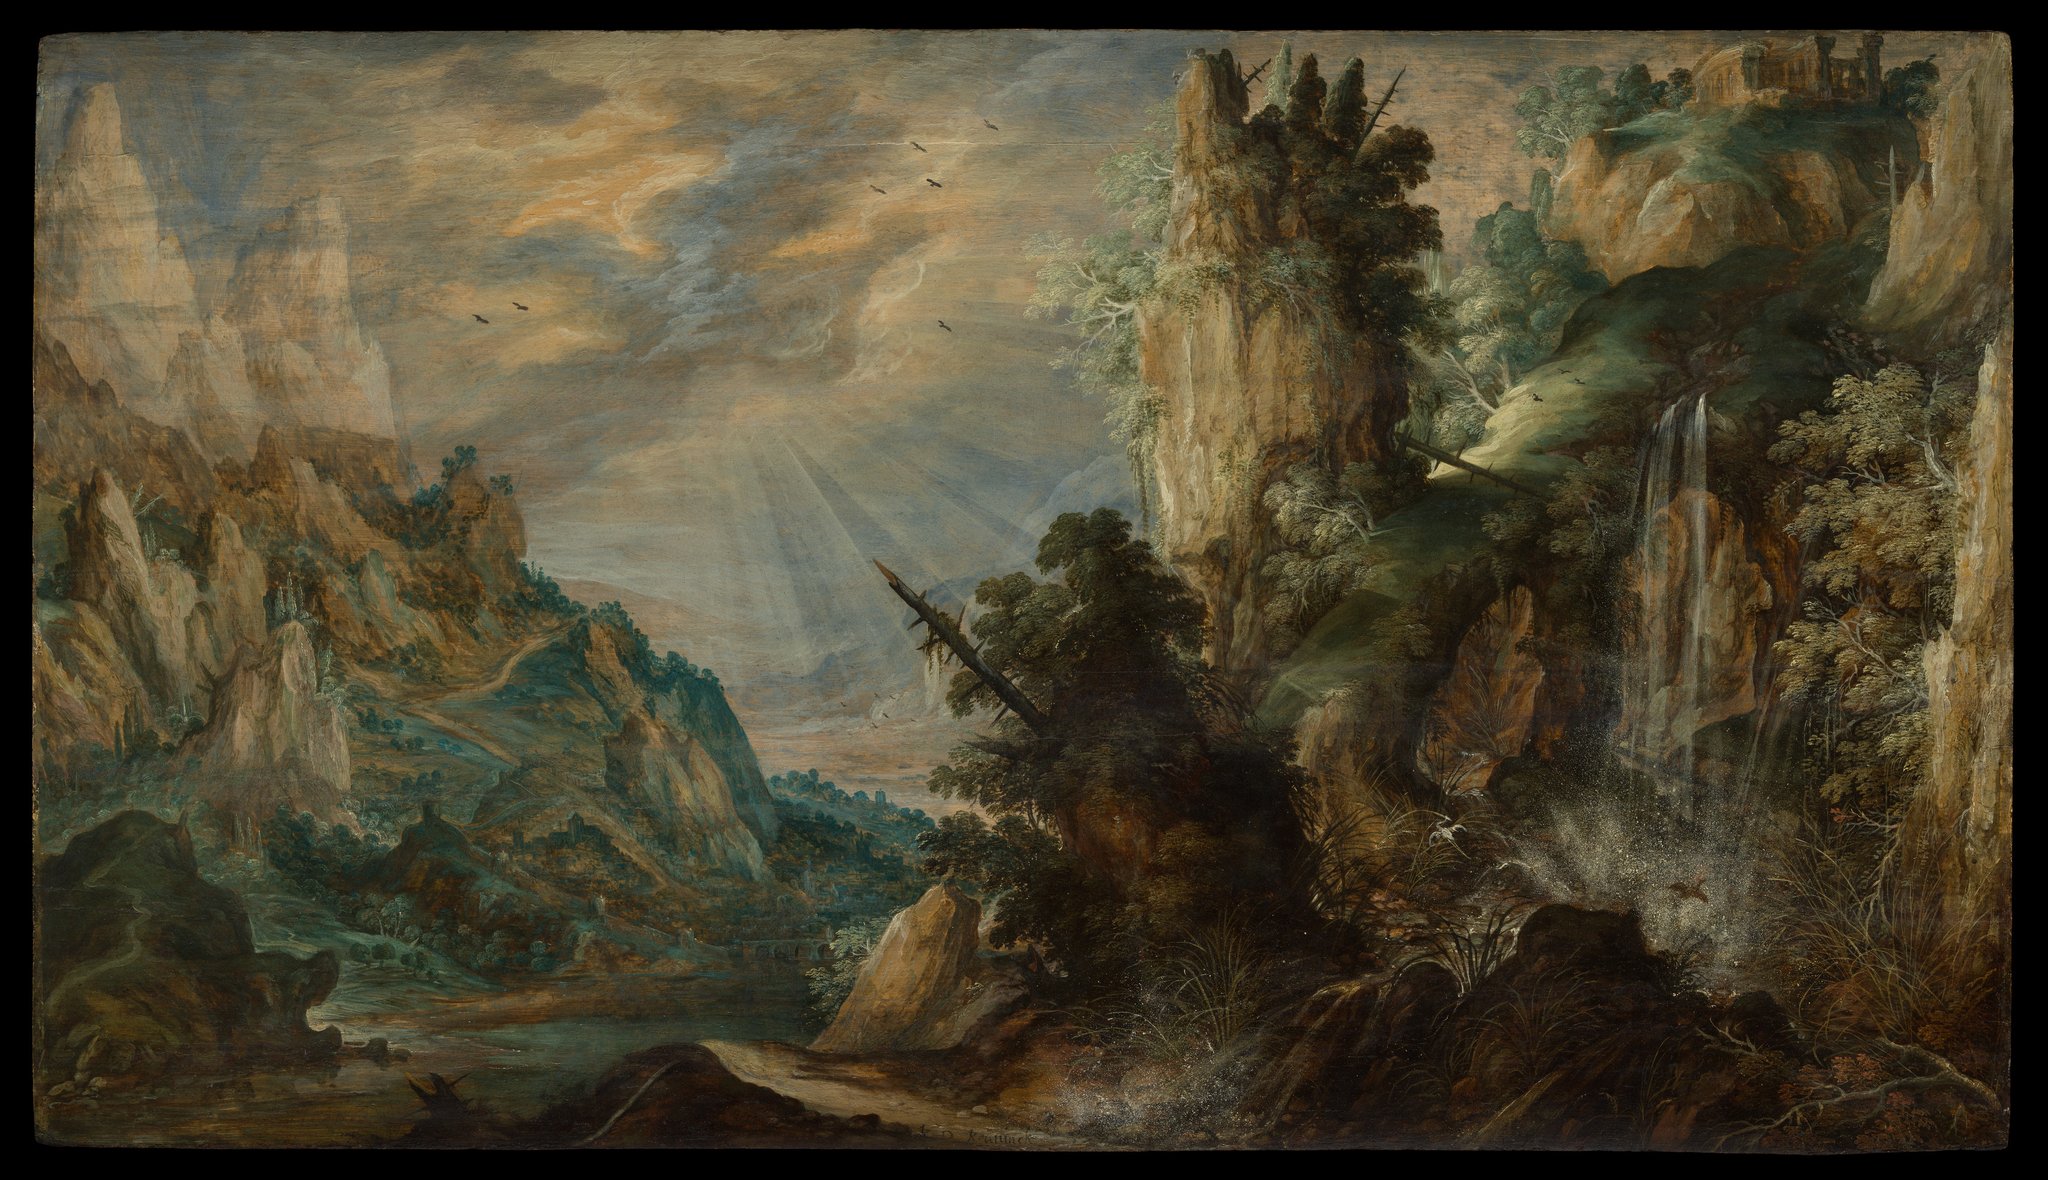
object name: painting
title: A Mountainous Landscape with a Waterfall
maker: kerstiaen de keuninck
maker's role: artist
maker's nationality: flemish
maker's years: 1560-1633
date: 1600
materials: oil, wood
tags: waterfalls,mountains,landscapes